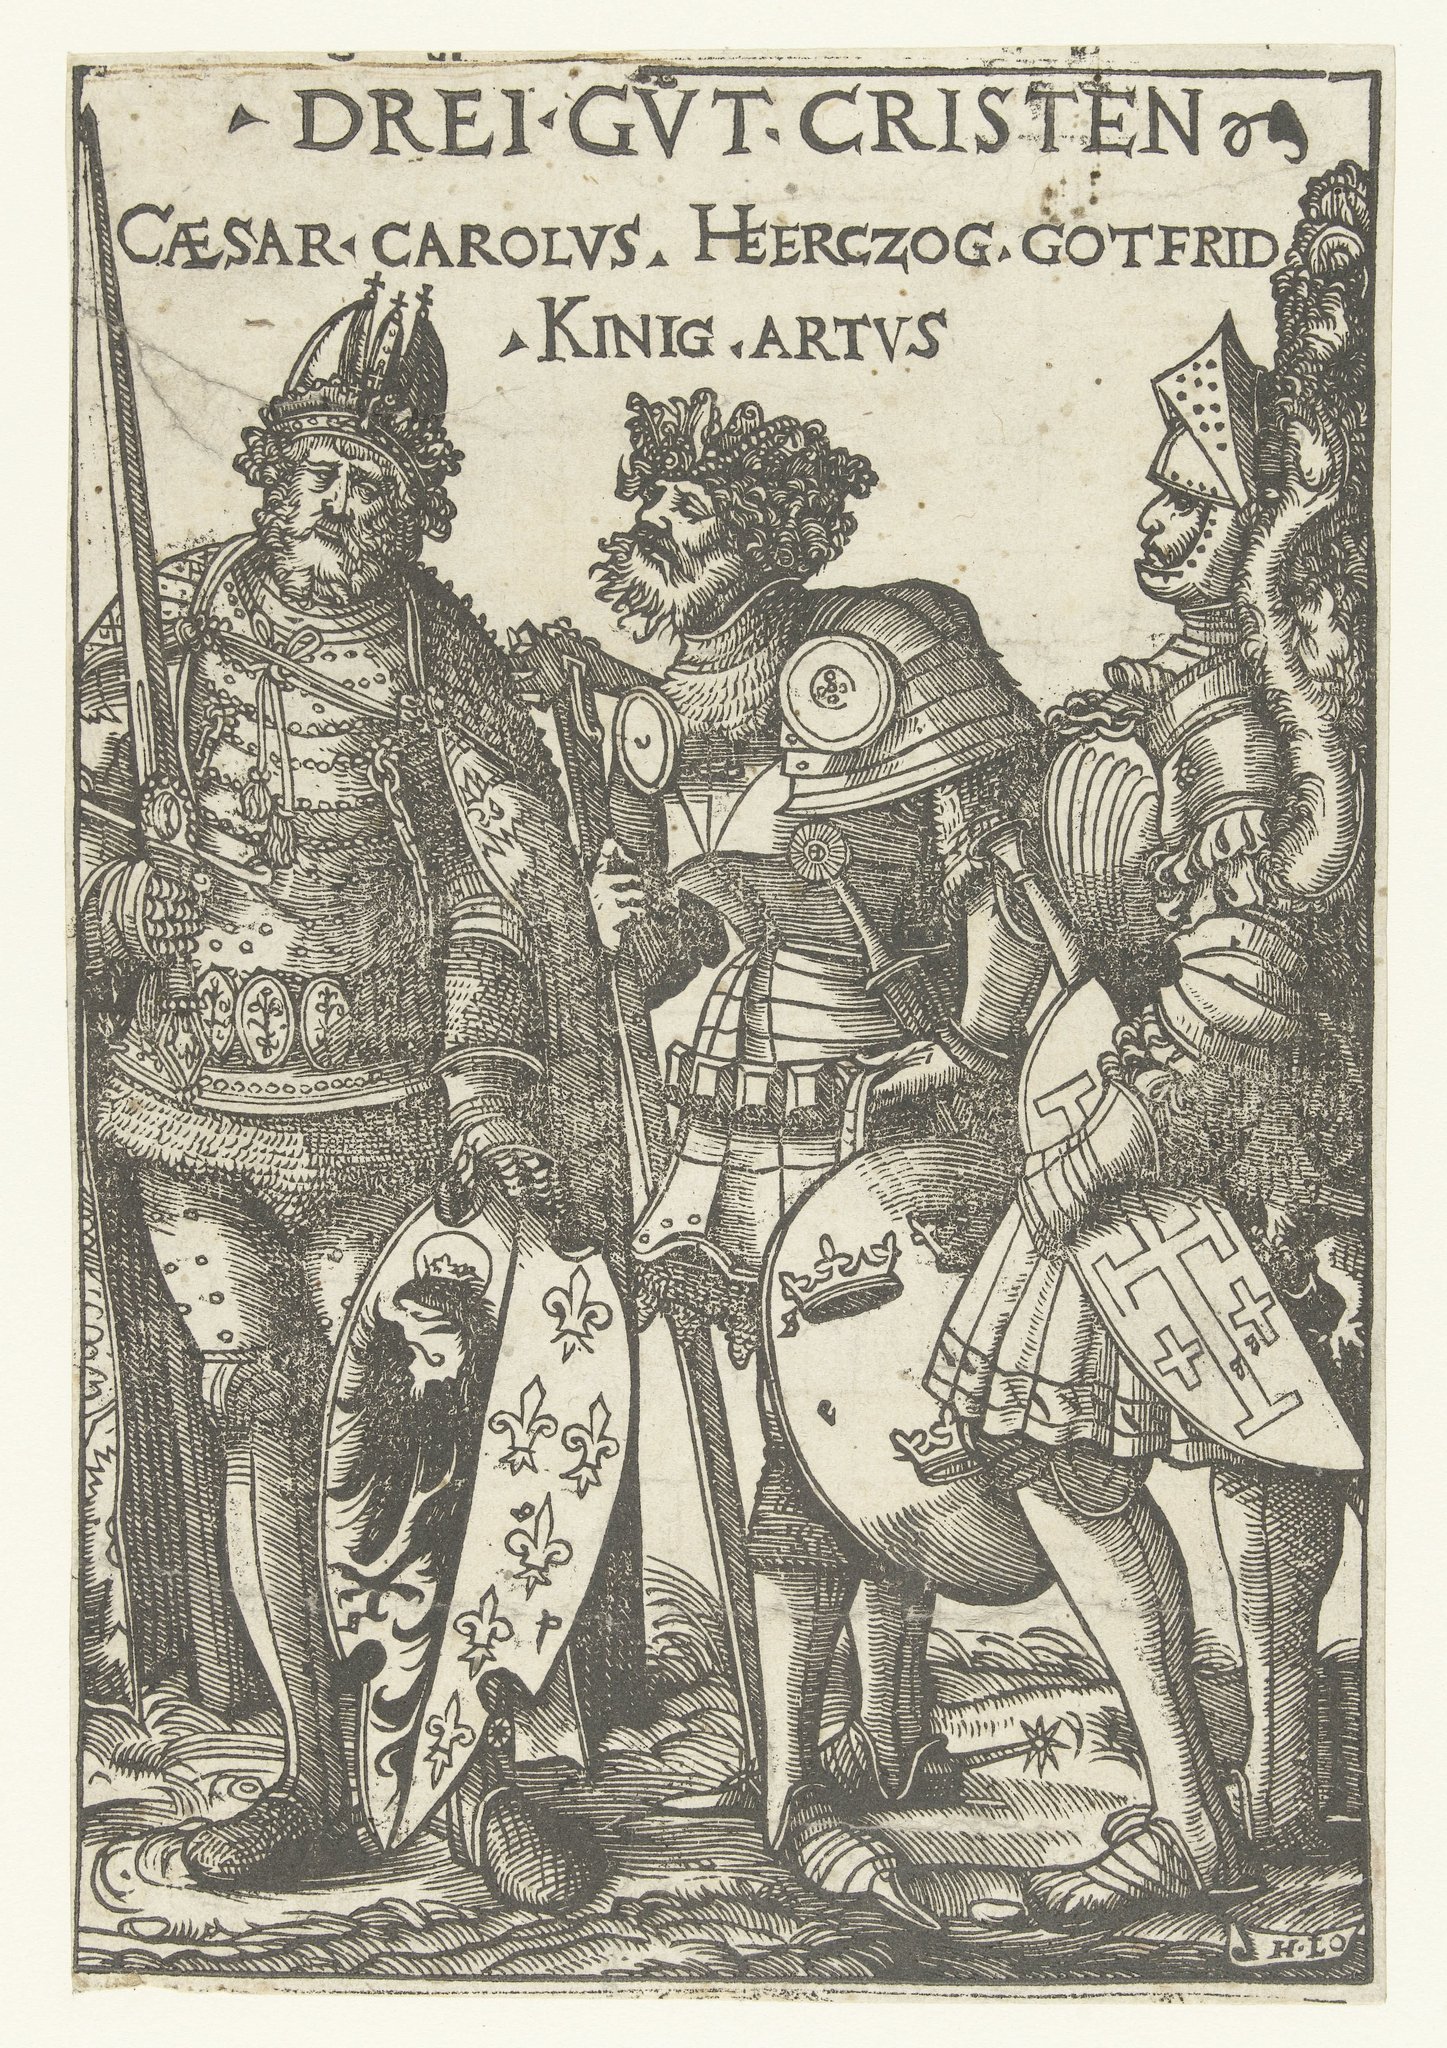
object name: print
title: Karel de Grote, Godfried IV van Bouillon en Koning Arthur als drie christelijke helden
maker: monogrammist hl (16e eeuw)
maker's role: print maker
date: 1516-1581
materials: paper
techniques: woodcut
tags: godfrey of bouillon, charlemagne (holy roman emperor), arthur (one of the nine worthies), godefroy of bouillon (one of the nine worthies), charlemagne (one of the nine worthies)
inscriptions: collector's mark: Lugt 240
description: Karel de Grote, Godfried IV van Bouillon en Koning Arthur gekleed in wapenrusting met hun persoonlijke wapens op de schilden die zij vasthouden. Zij worden in deze serie gepresenteerd als de drie christelijke helden zoals blijkt uit de Duitse tekst op de prent en de namen van de drie mannen: Caesar Carolvs Heerczog Gotfrid Kinig Artvs.